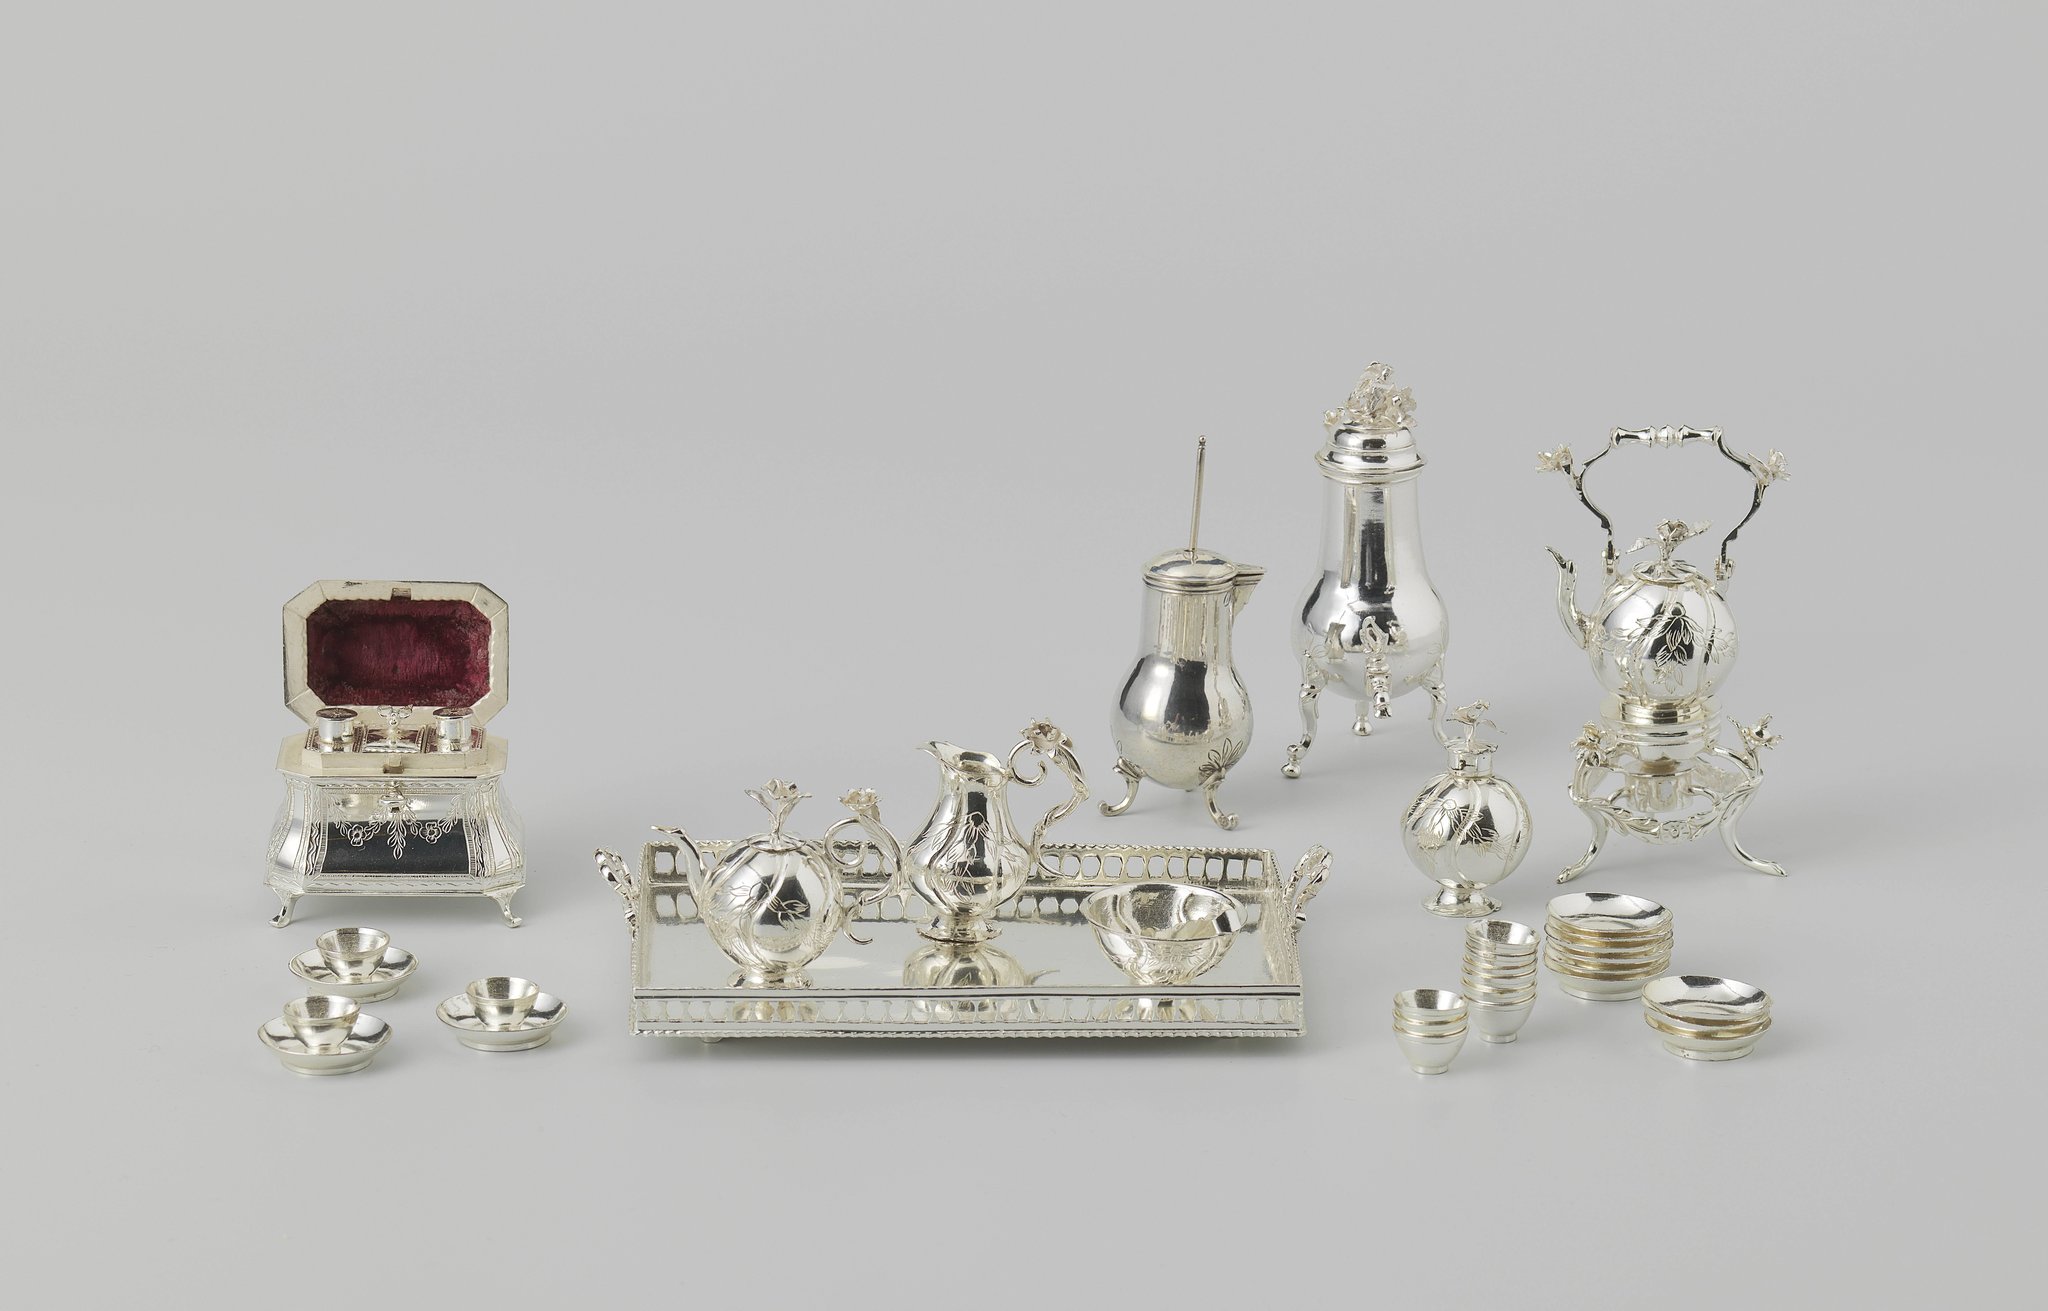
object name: miniature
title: Suikertang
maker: hendrik duller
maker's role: silversmith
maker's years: 1749-1820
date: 1776-1811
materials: silver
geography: amsterdam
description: Suikertang met twee benen. De rand van de tang is geschulpt en de benen zijn gegraveerd. De suikertang is niet gemerkt. De suikertang wordt bewaard in een suikerkom (BK-NM-11177-142-p) en als onderdeel van een theeservies (BK-NM-11177-142).